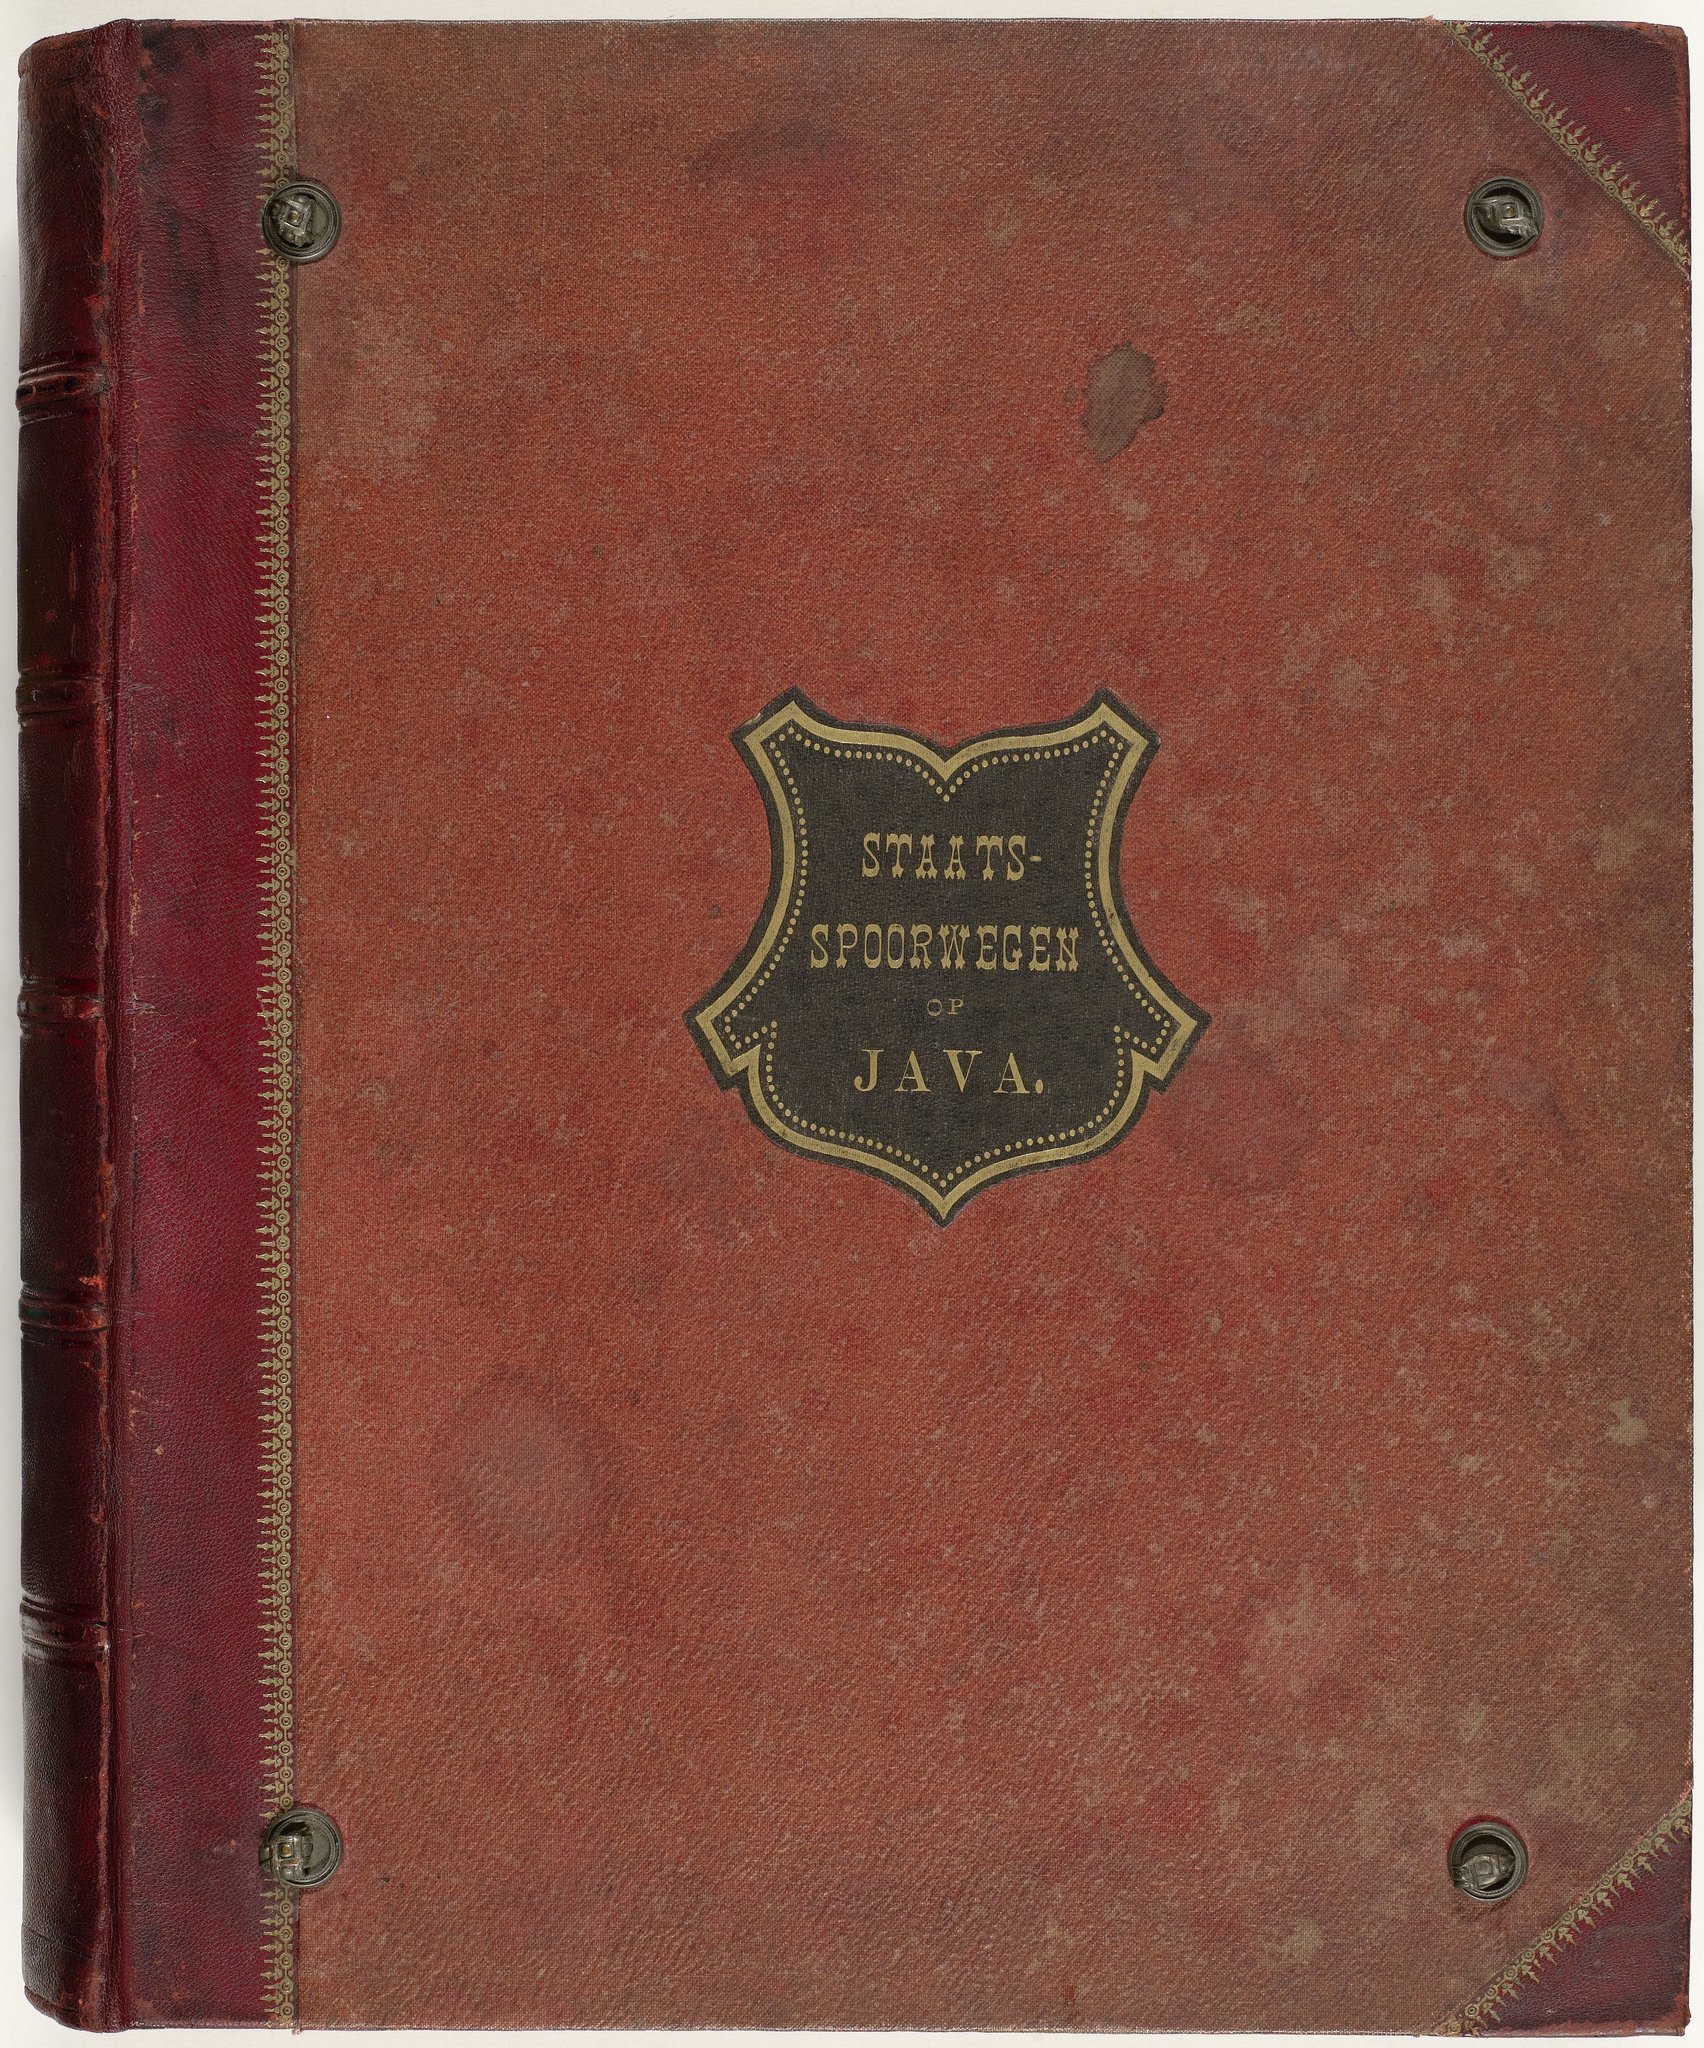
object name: box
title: Groep van 62 foto's in een doos met het opschrift "Staatsspoorwegen op Java" uit 1888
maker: Anonymous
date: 1888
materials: cardboard, leather, metal, paper, textile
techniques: bookbinding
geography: surabaya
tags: java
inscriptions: inscription: ‘Staatsspoorwegen op Java’, date: ‘ANN 88’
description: Foto's gemaakt van de Staatsspoorwegen op Java gemaakt door H. Salzwedel werkzaam in Surabaya tussen 1880 en 1905. De machtiging voor de aanleg van de eerste staatsspoorweg op Java werd in 1875 uitgegeven. Het was de lijn Surabaya-Pasuruan-Malang. De eerste particuliere spoorlijn was al in 1862 in gebruik genomen. Dit was de lijn Semarang-Vorstenlanden.